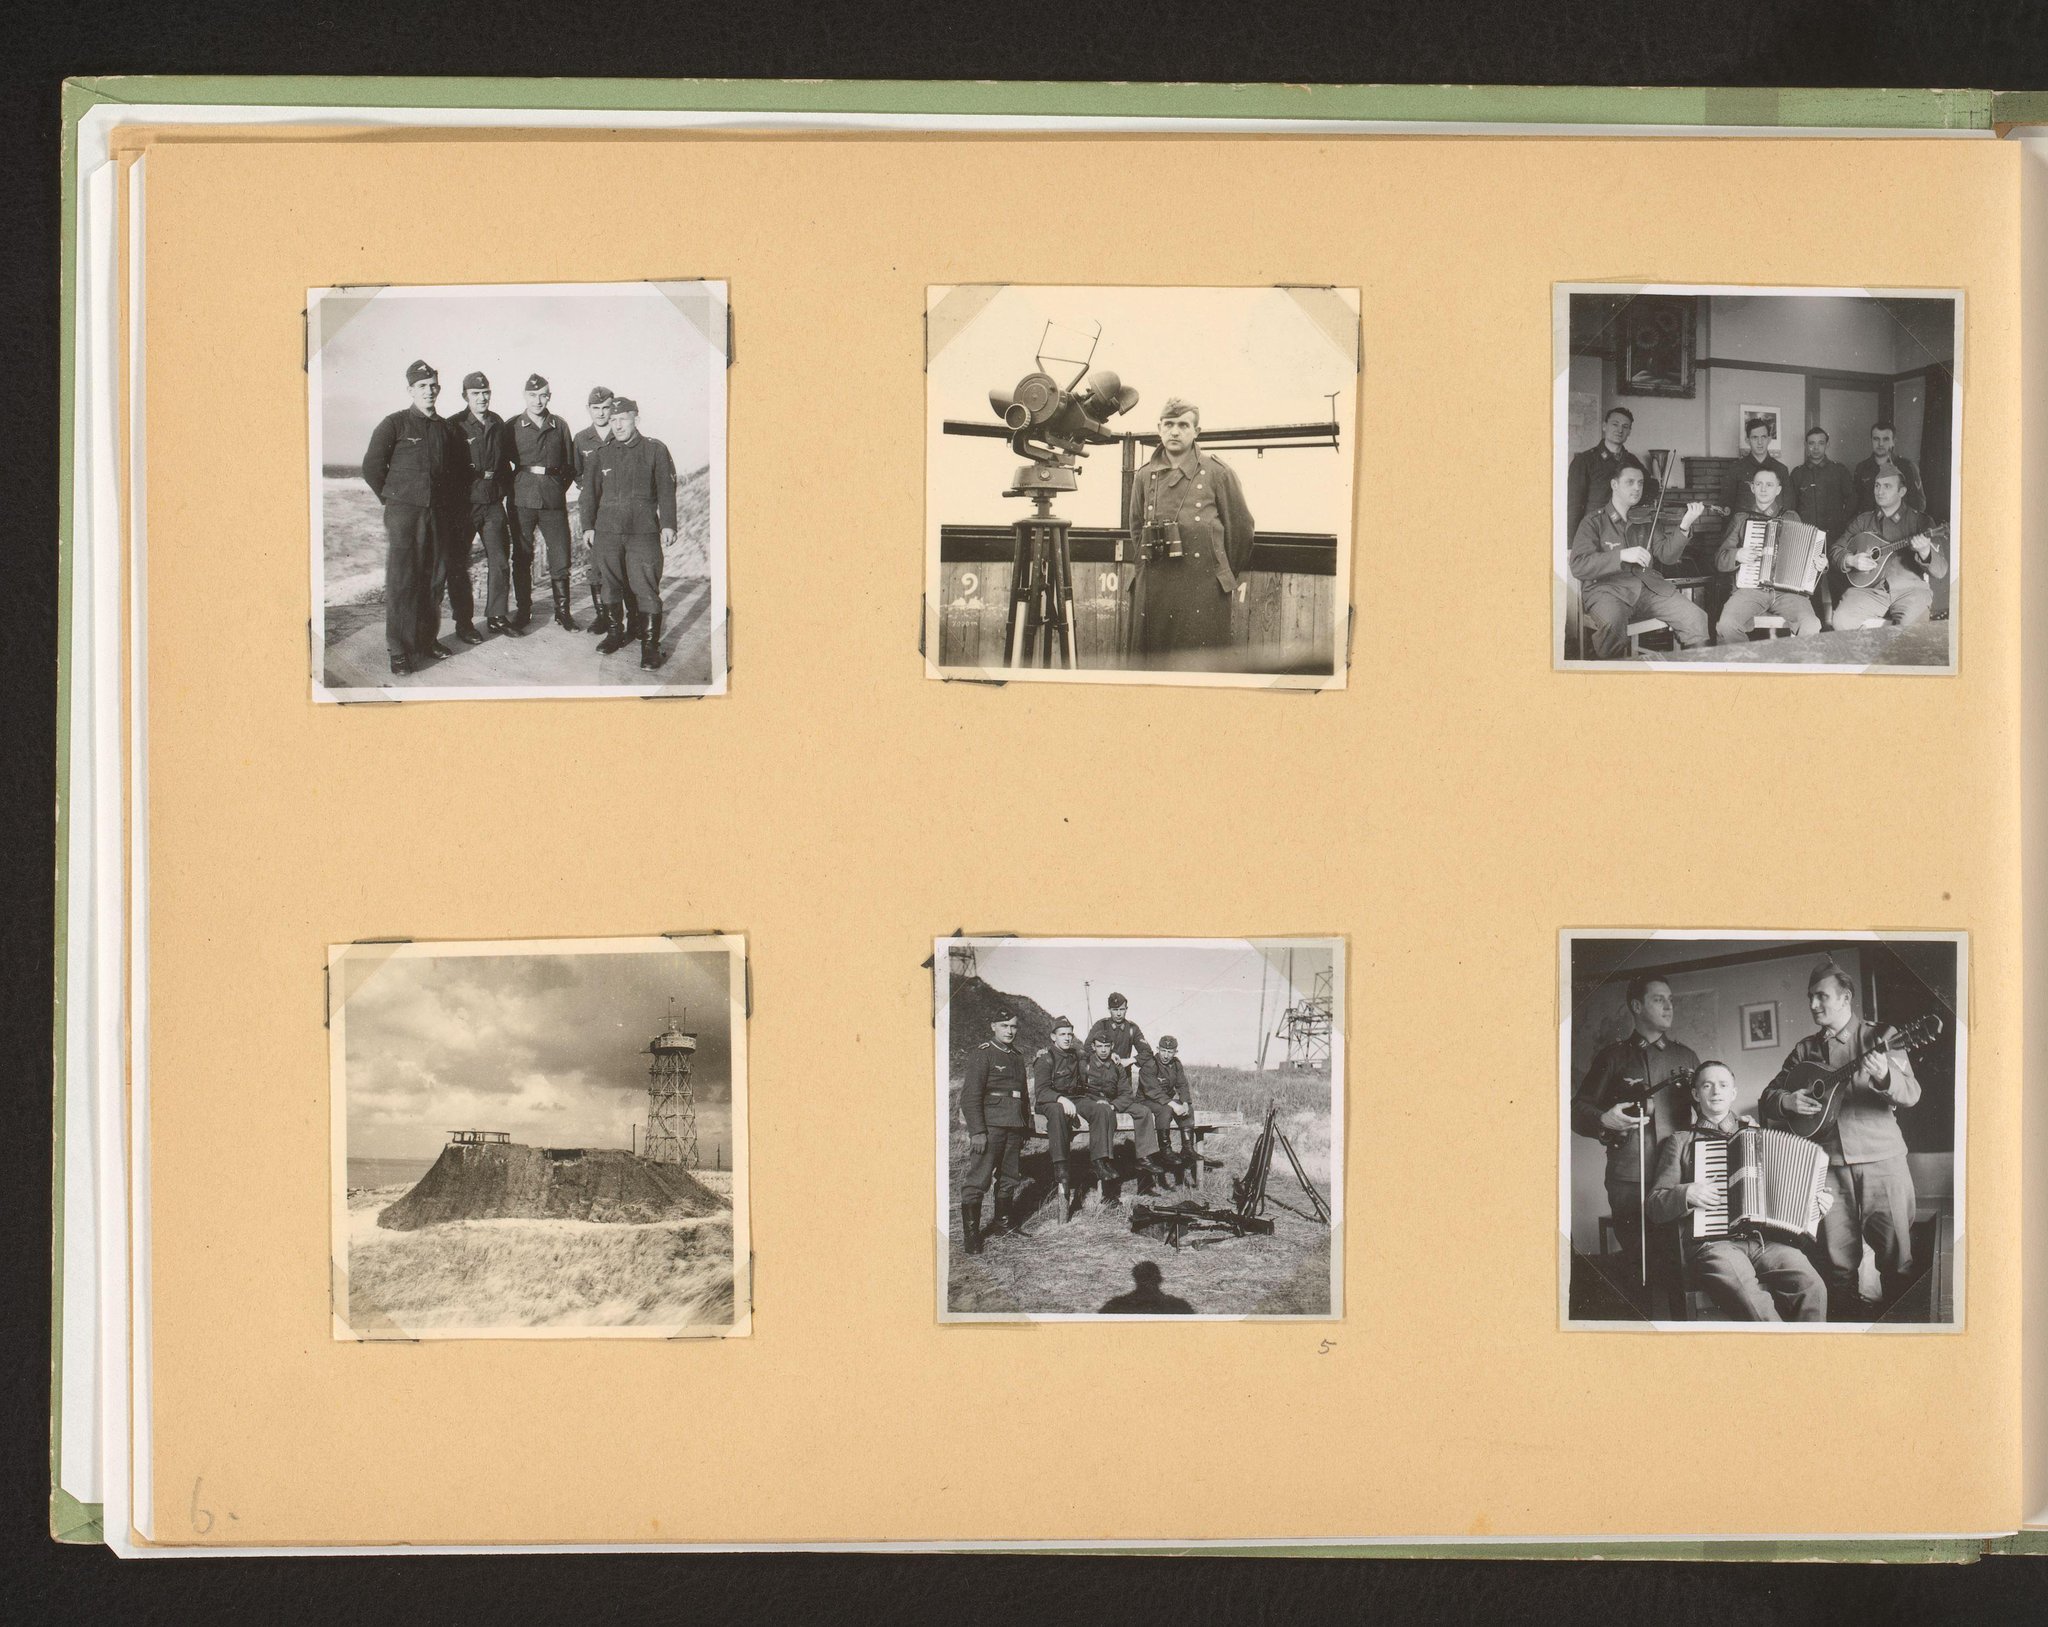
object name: photograph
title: Groep militairen tijdens hun werk en tijdens hun vrije tijd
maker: Anonymous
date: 1940-1944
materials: paper, photographic support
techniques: gelatin silver print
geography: netherlands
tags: dune coast, the company, the unit, the troop ~ military service, recreation ~ the soldier off duty, permanent fortifications, more than one musician with instrument, netherlands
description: Albumblad met zes foto's van Duitse militairen tijdens hun werk op en bij de bunker aan de Nederlandse kust en muziek makend in een huis tijdens hun vrije tijd. Ook een foto van een bunker met wachttoren. Onderdeel van het fotoalbum Bewaking bunkers.